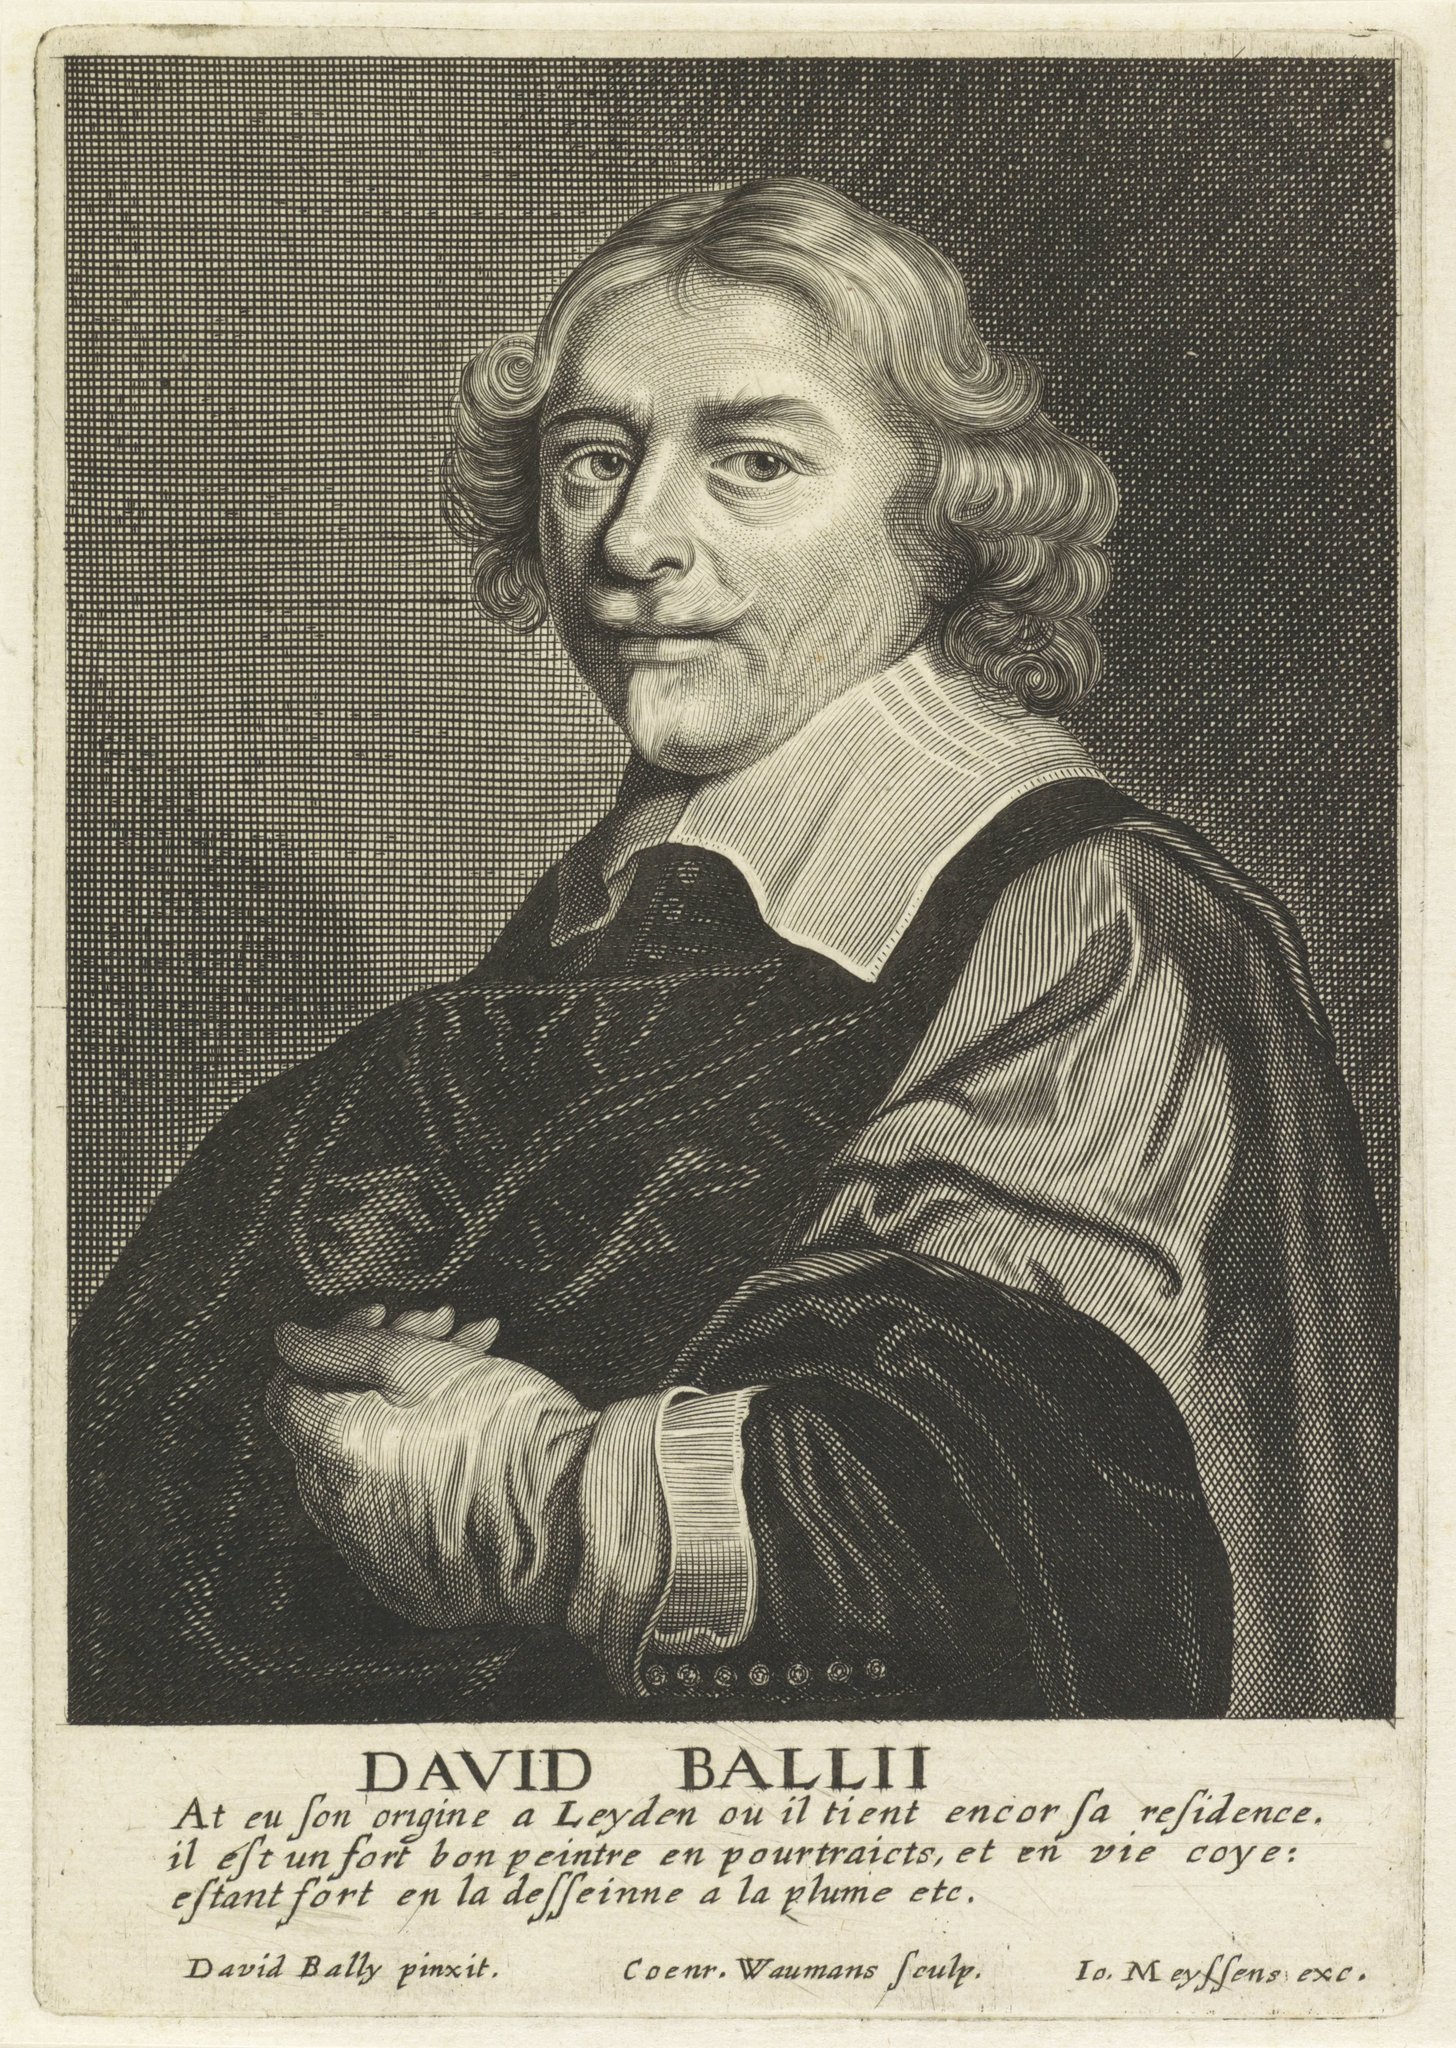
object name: print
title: Portret van de schilder David Bailly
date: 1649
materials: paper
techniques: engraving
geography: antwerp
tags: leiden, draughtsman, david bailly, portrait, self-portrait of painter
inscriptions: collector's mark: Lugt 2228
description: Prent gebruikt in: Image de divers hommes d'esprit sublime, qui par leur art et science devraient vivre éternellement et desquels la louange et renommée faict estonner le monde. Antwerpen: J. Meyssens, 1649.